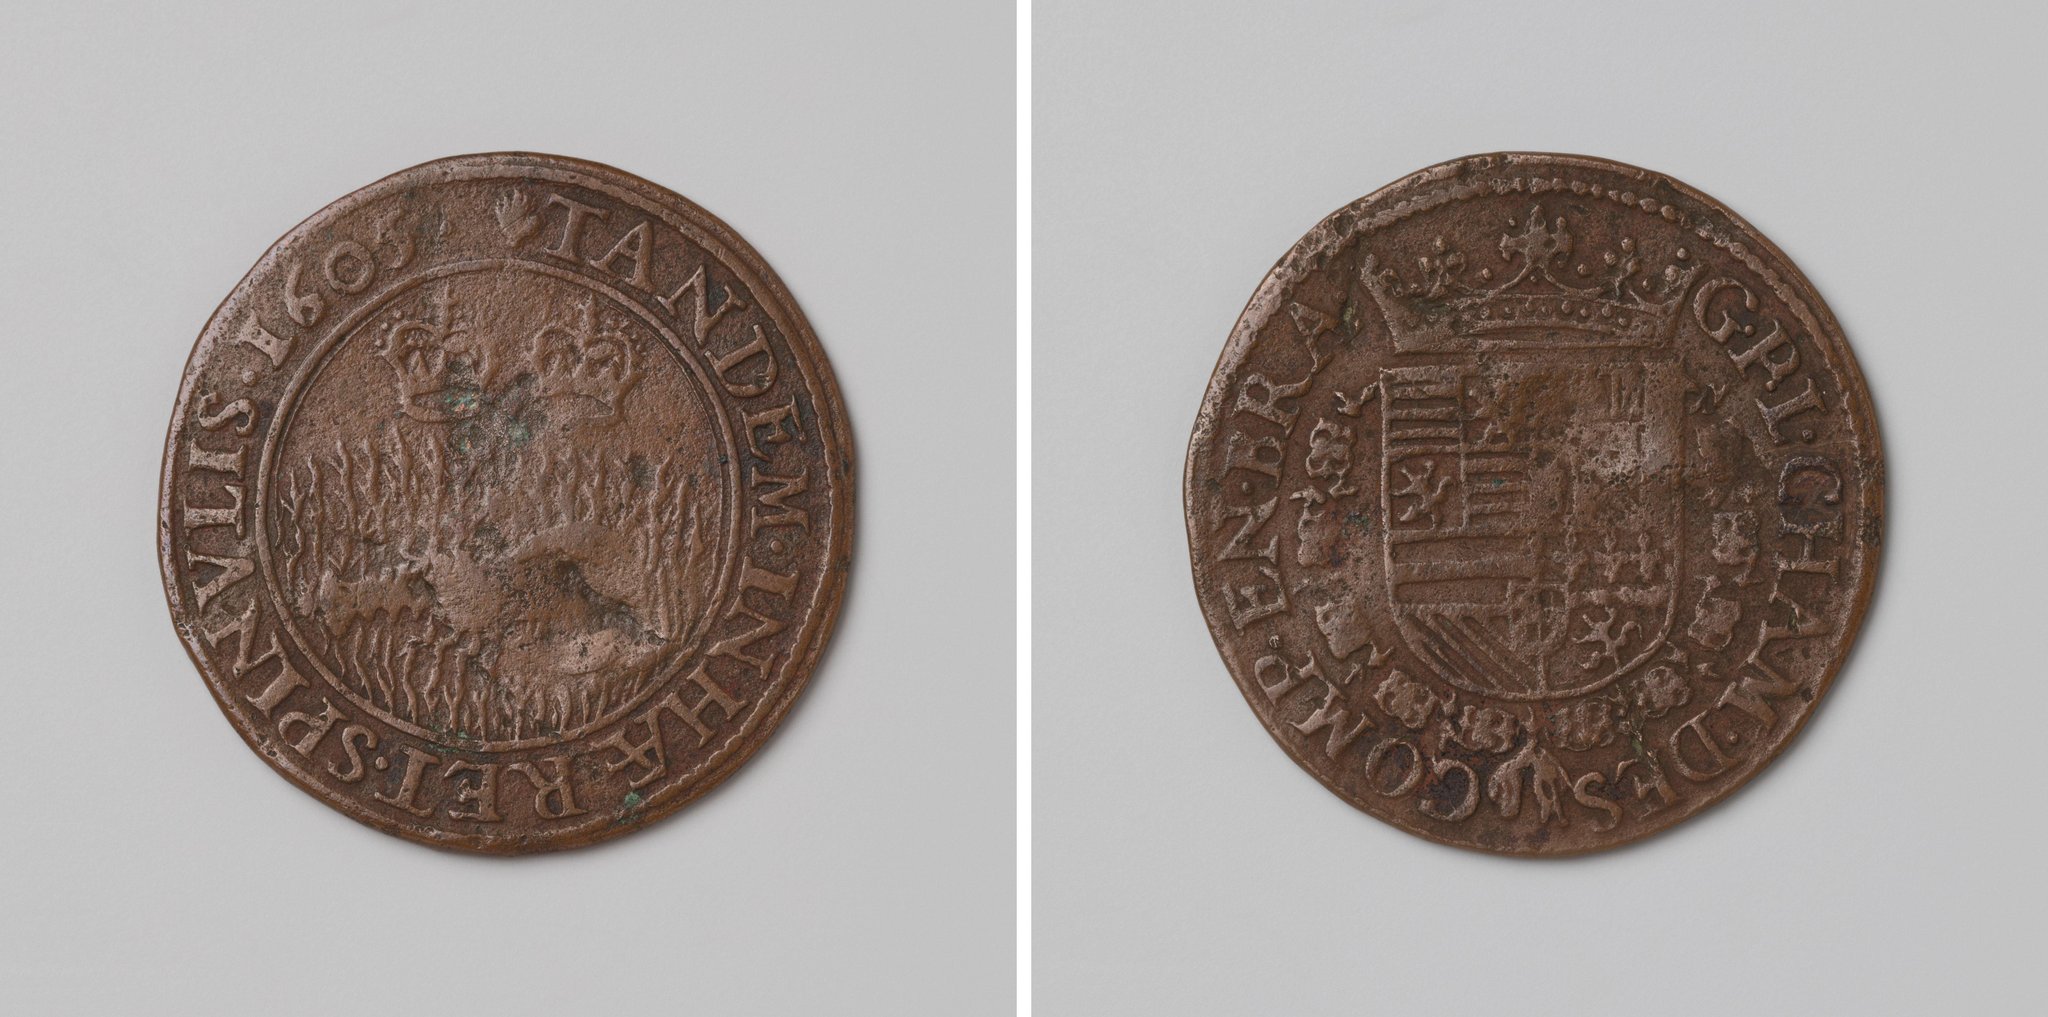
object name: jeton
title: Overgave van Oostende, rekenpenning van de rekenkamer van Brabant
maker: Anonymous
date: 1605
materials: copper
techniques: striking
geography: antwerp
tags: infante van spanje isabella clara eugenia, albrecht aartshertog van oostenrijk, brabant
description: Koperen penning. Voorzijde: kreeft temidden van doornstruiken, refererend aan veldheer Spinola, onder twee kronen binnen omschrift. Keerzijde: gekroond wapenschild, omhangen met de orde van het Gulden Vlies binnen omschrift